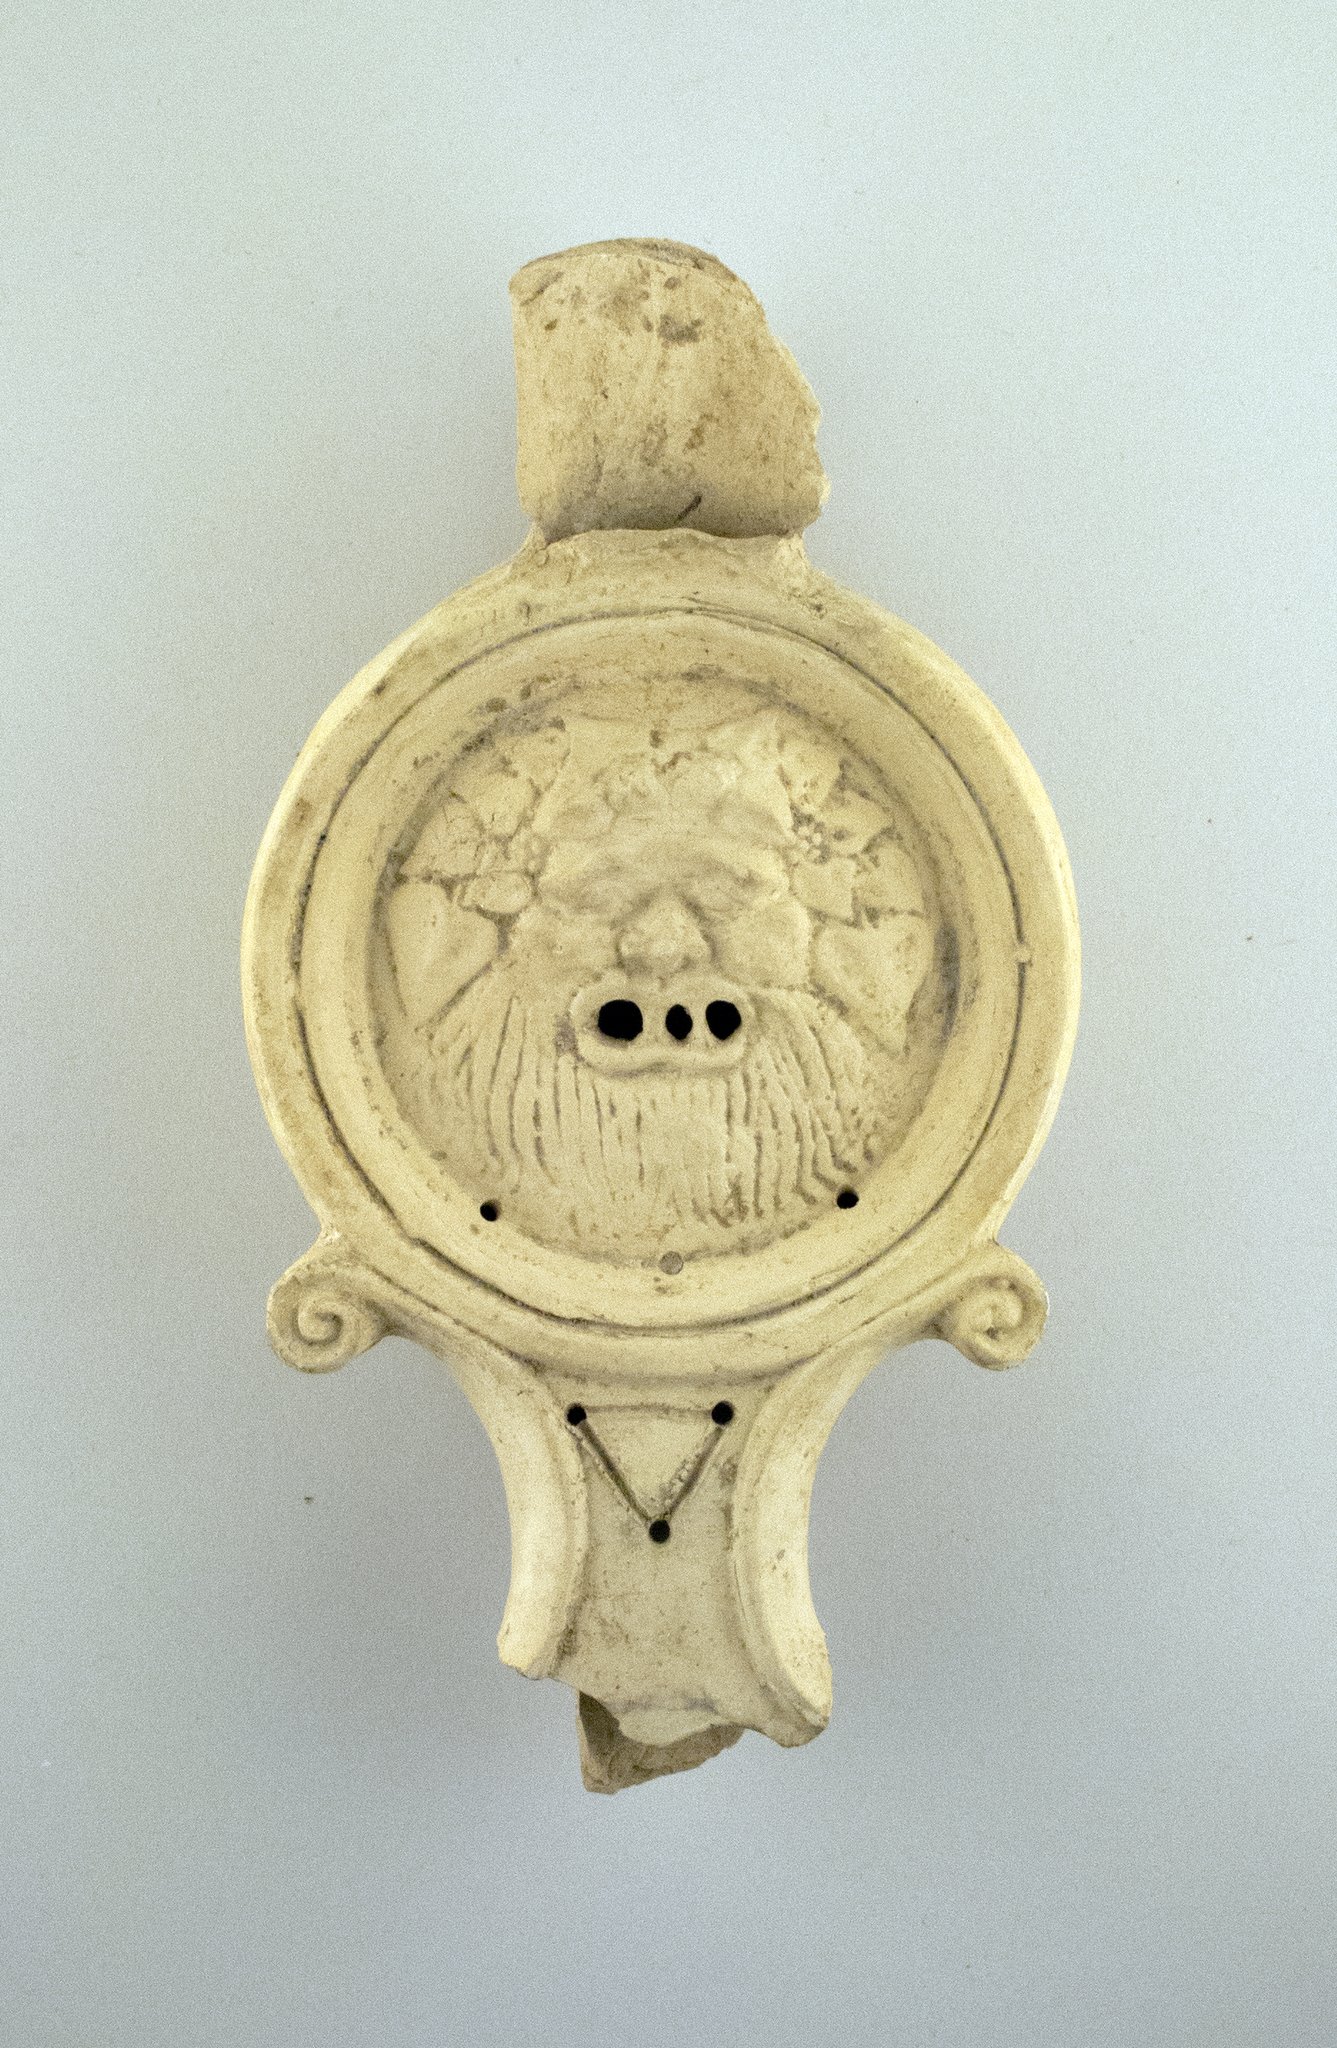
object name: lamp in the form of a satyr's mask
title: Terracotta lamp in the form of a satyr's mask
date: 7000 BCE-330 CE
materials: terracotta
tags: satyrs